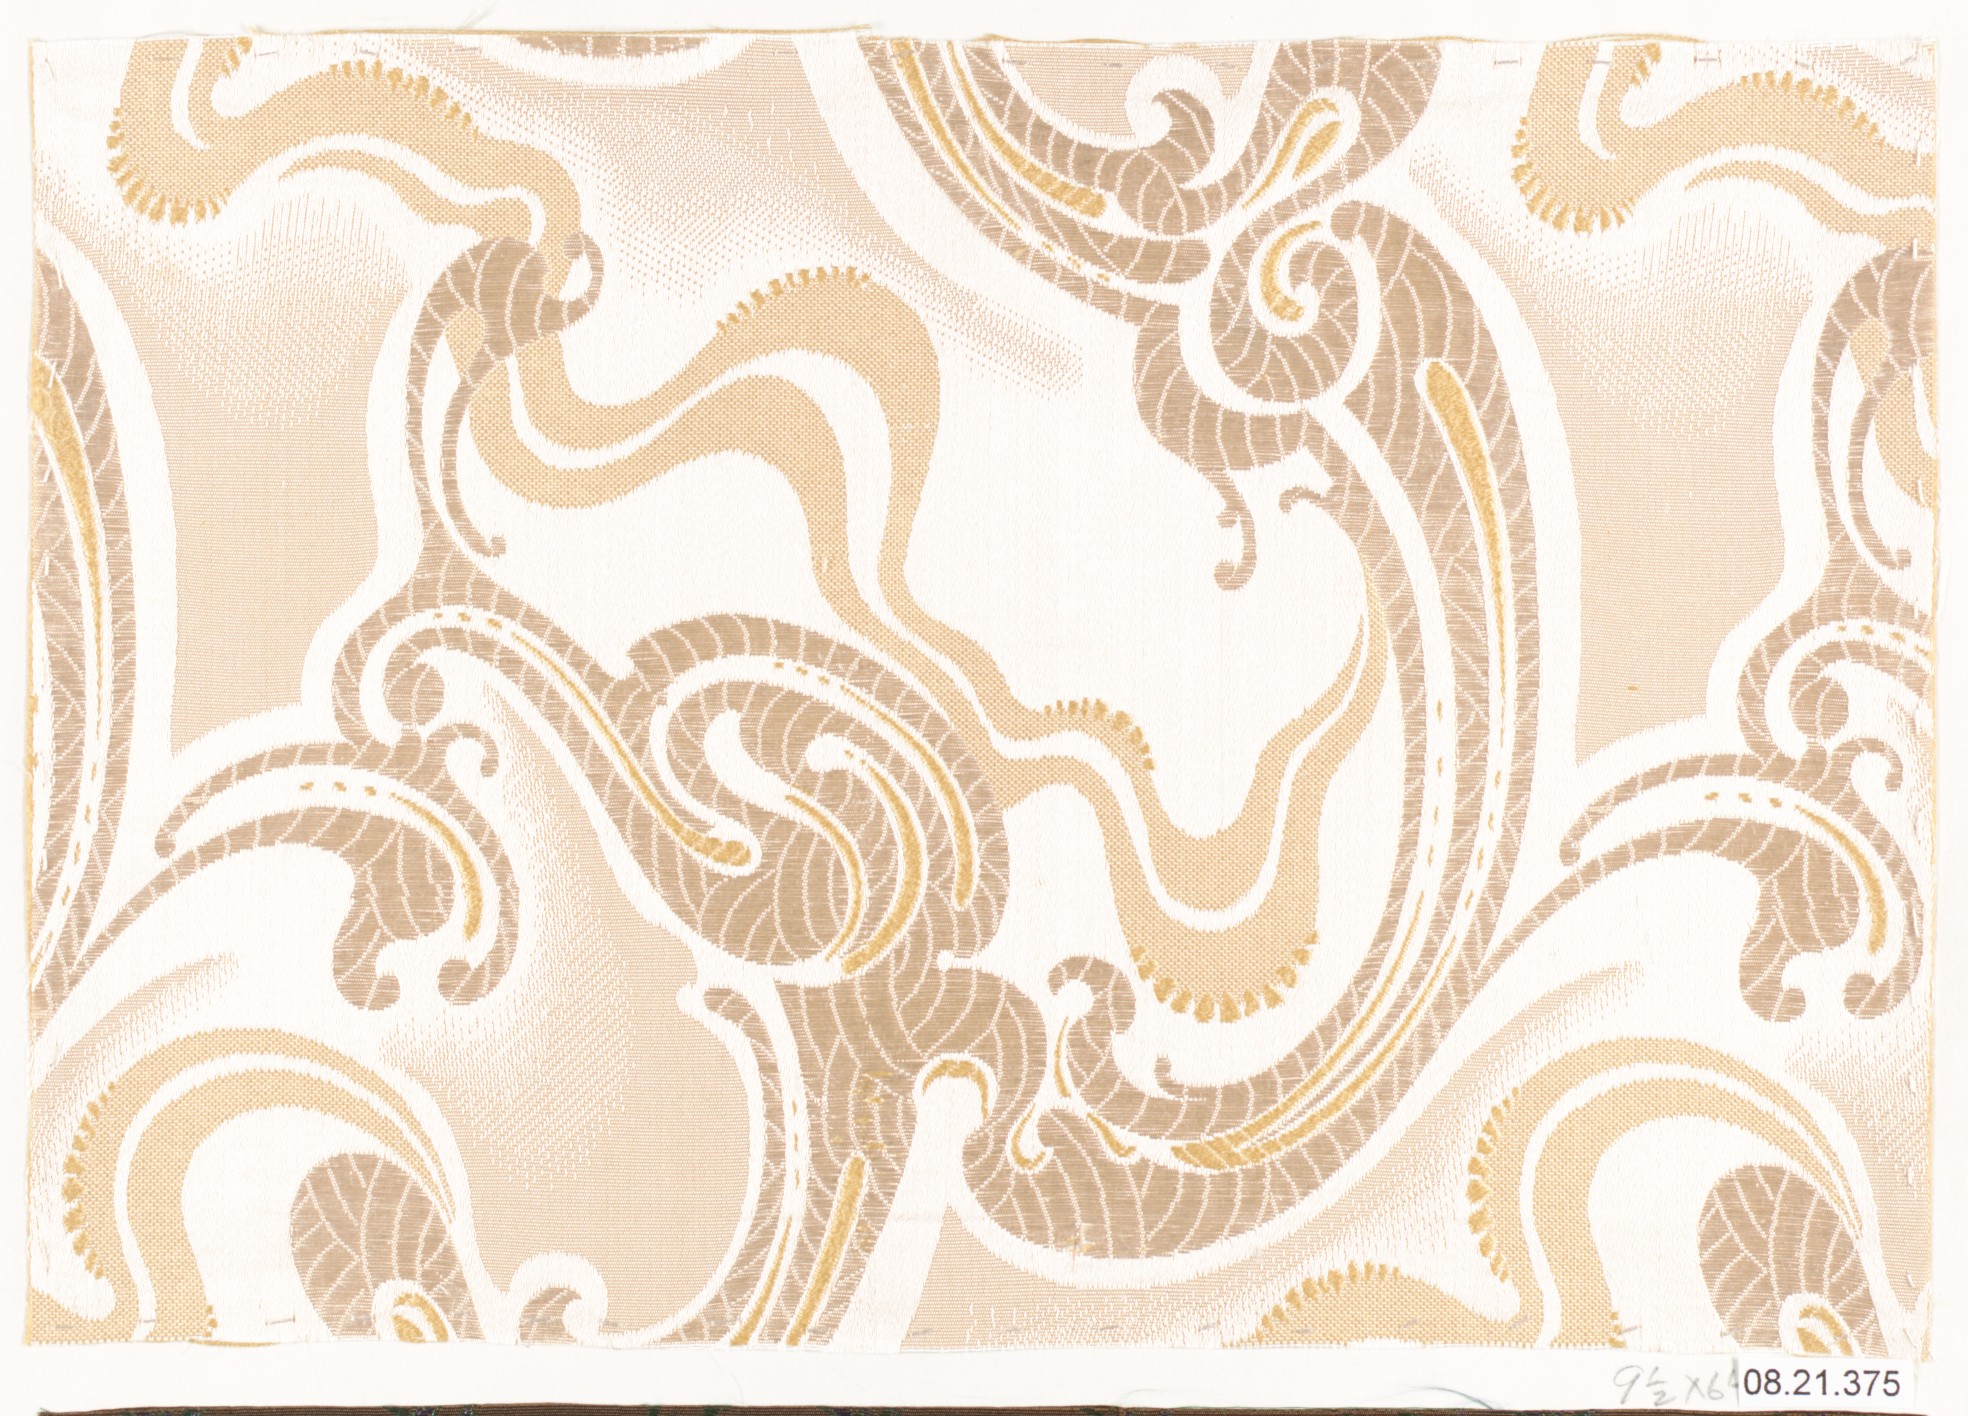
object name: textile sample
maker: Anonymous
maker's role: designer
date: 1900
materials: silk